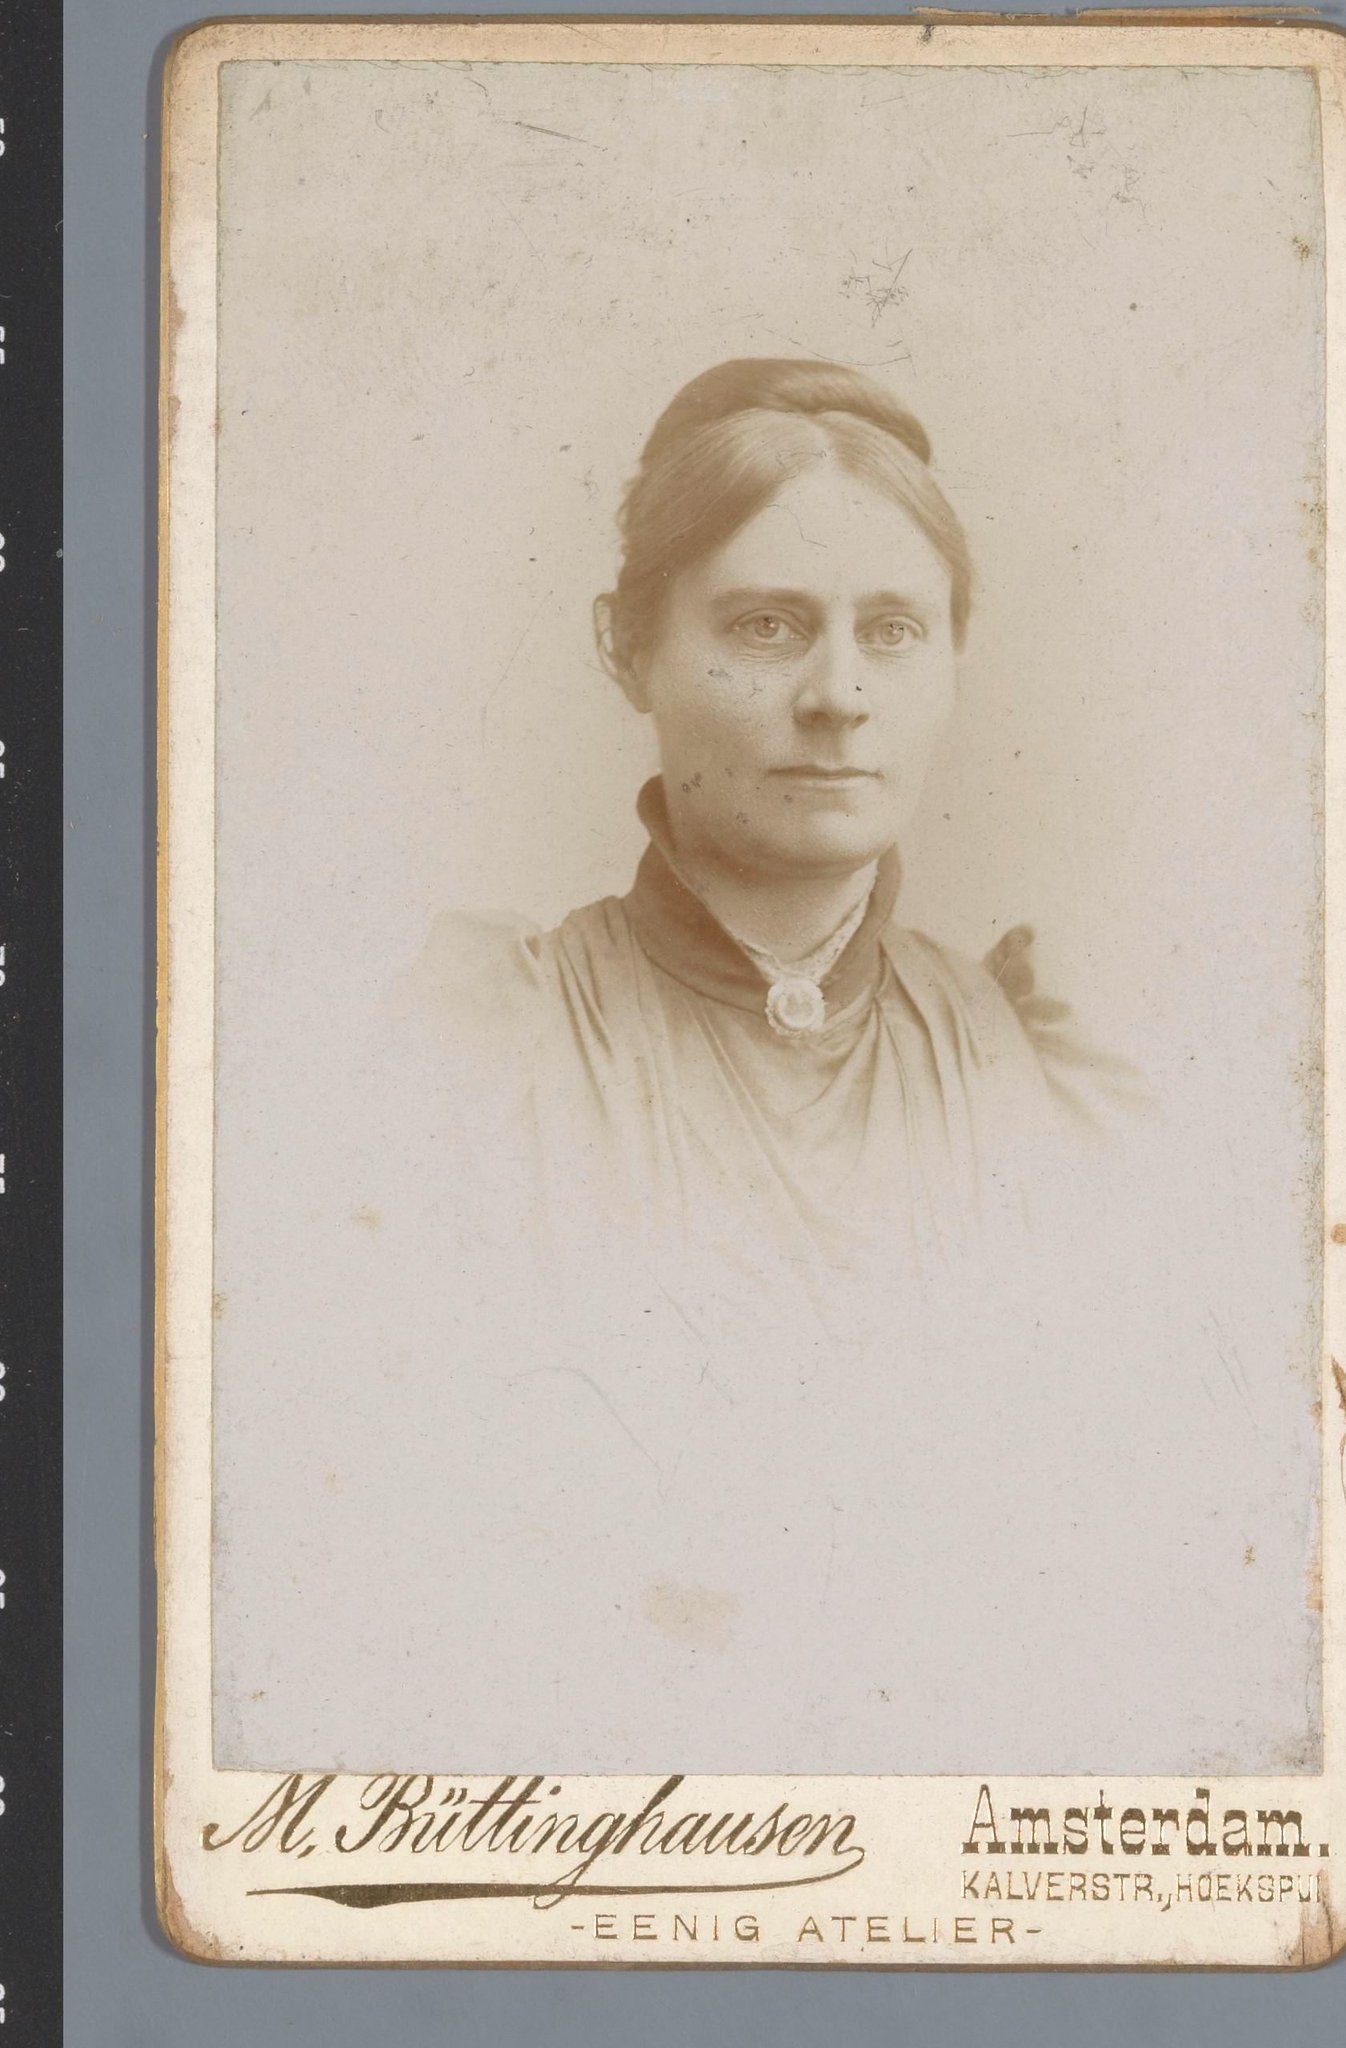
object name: carte de visite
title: Portret van een onbekende vrouw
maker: max büttinghausen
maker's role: fotograaf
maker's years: 1847-1906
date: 1879-1886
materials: cardboard, paper, photographic support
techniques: daylight paper print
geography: amsterdam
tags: adult woman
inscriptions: inscription: ‘28 April 96. [...]’, name: ‘M. Büttinghausen Amsterdam. Kalverstr. Hoek Spui - Eenig Atelier-’, inscription: ‘Specialiteit in Vergrootingen Kooldruk Onveranderlijk M. Büttinghausen Amsterdam -Eenig Atelier- Kalverstraat, hoek Spui. De plaat blijft ter nabestelling bewaard.’